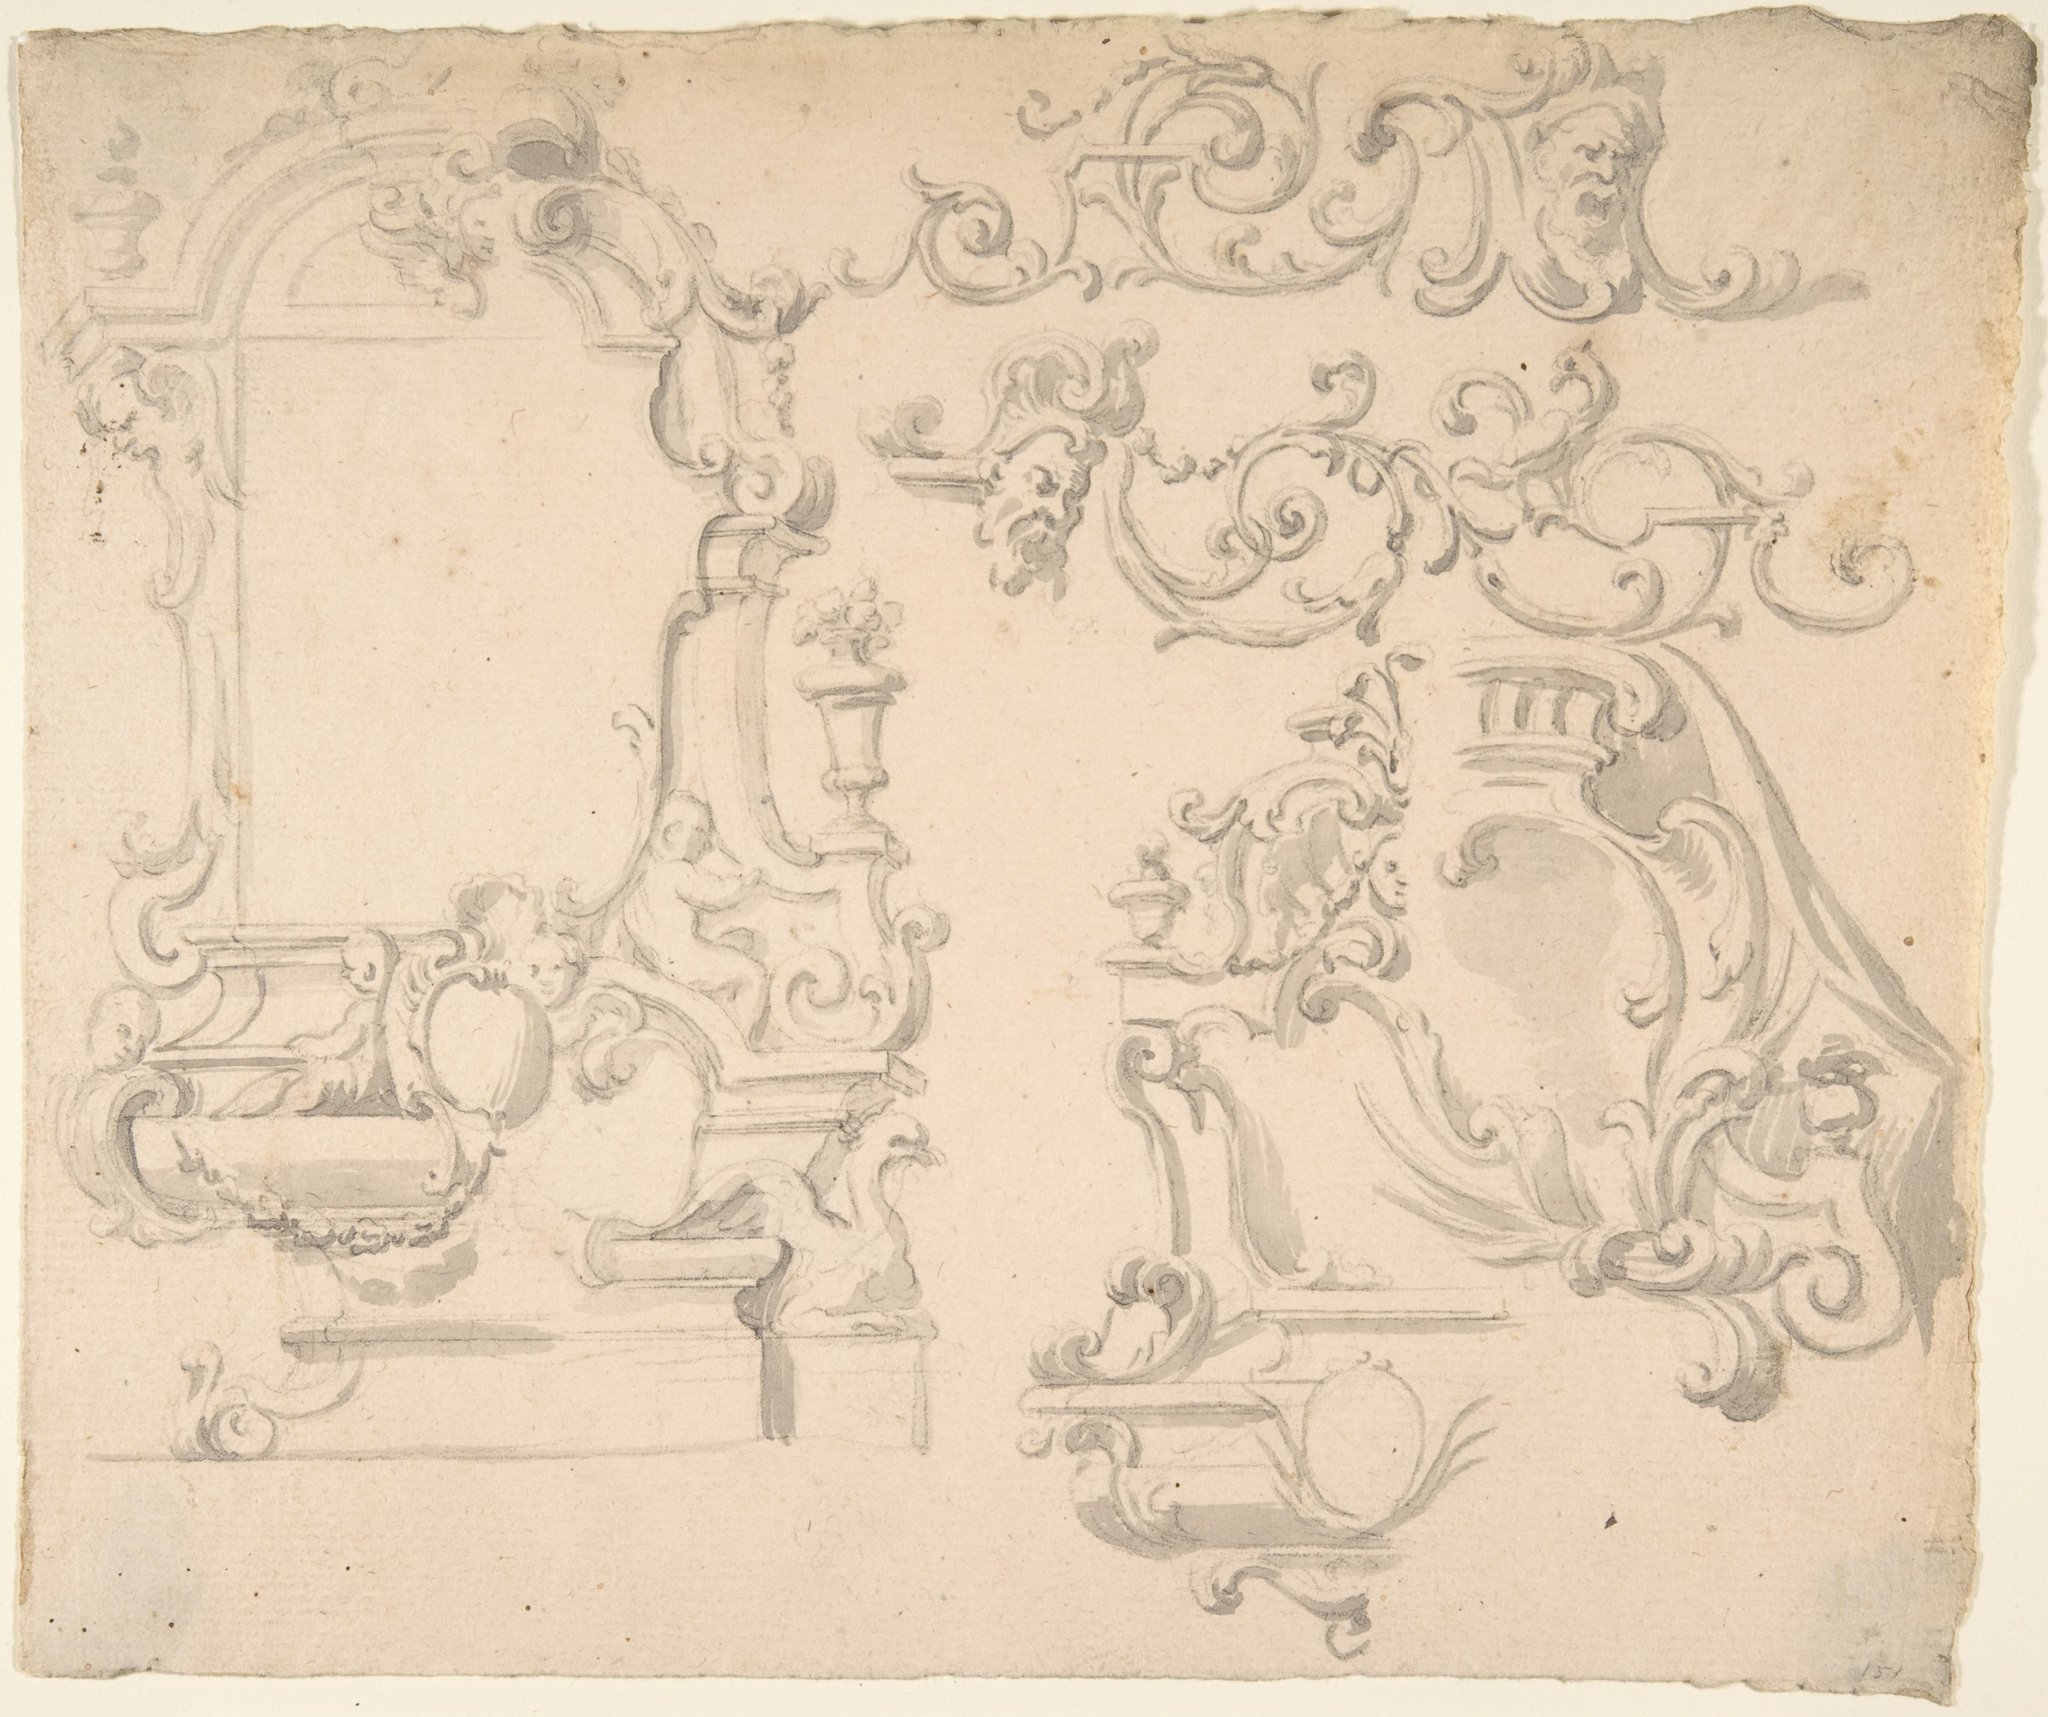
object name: drawing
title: Designs for Wall Ensemble with Scroll and Grotesque Motifs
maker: anonymous, italian, piedmontese, 18th century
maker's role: artist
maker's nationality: italian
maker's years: 1700-1800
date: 1700-1780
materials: chalk, drawing material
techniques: brush, wash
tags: grotesques